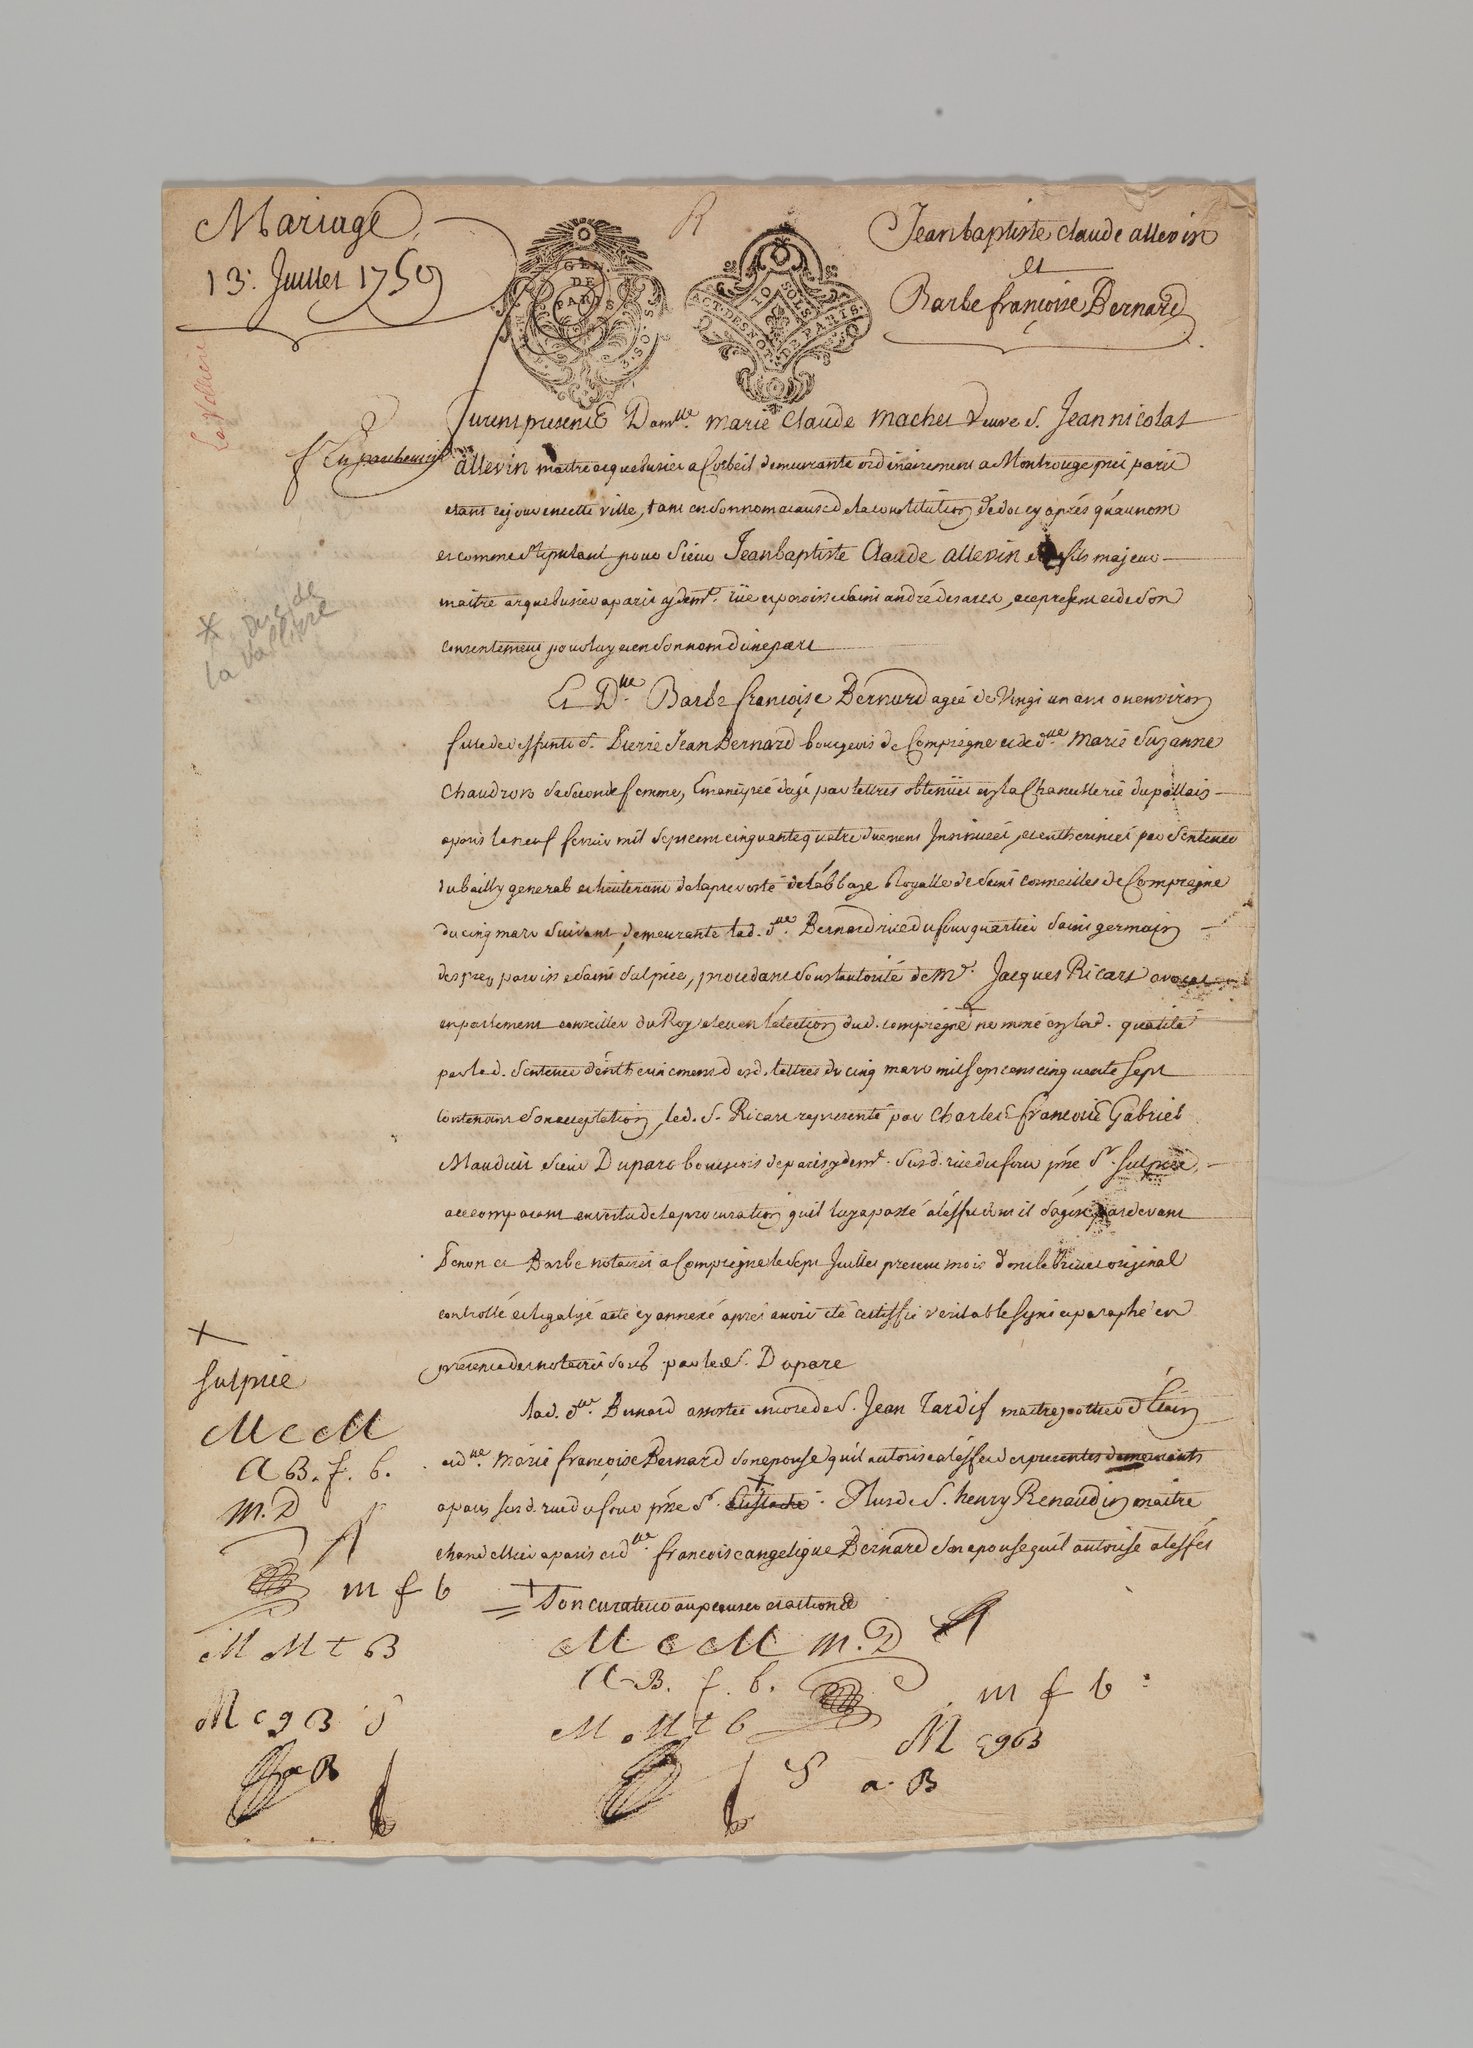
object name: marriage contract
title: Marriage Contract Between Jean Baptiste Claude Allevin, Gunmaker, and Barbe Françoise Bernard, Paris, July 13, 1759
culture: french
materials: paper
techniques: pen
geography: france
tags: documents